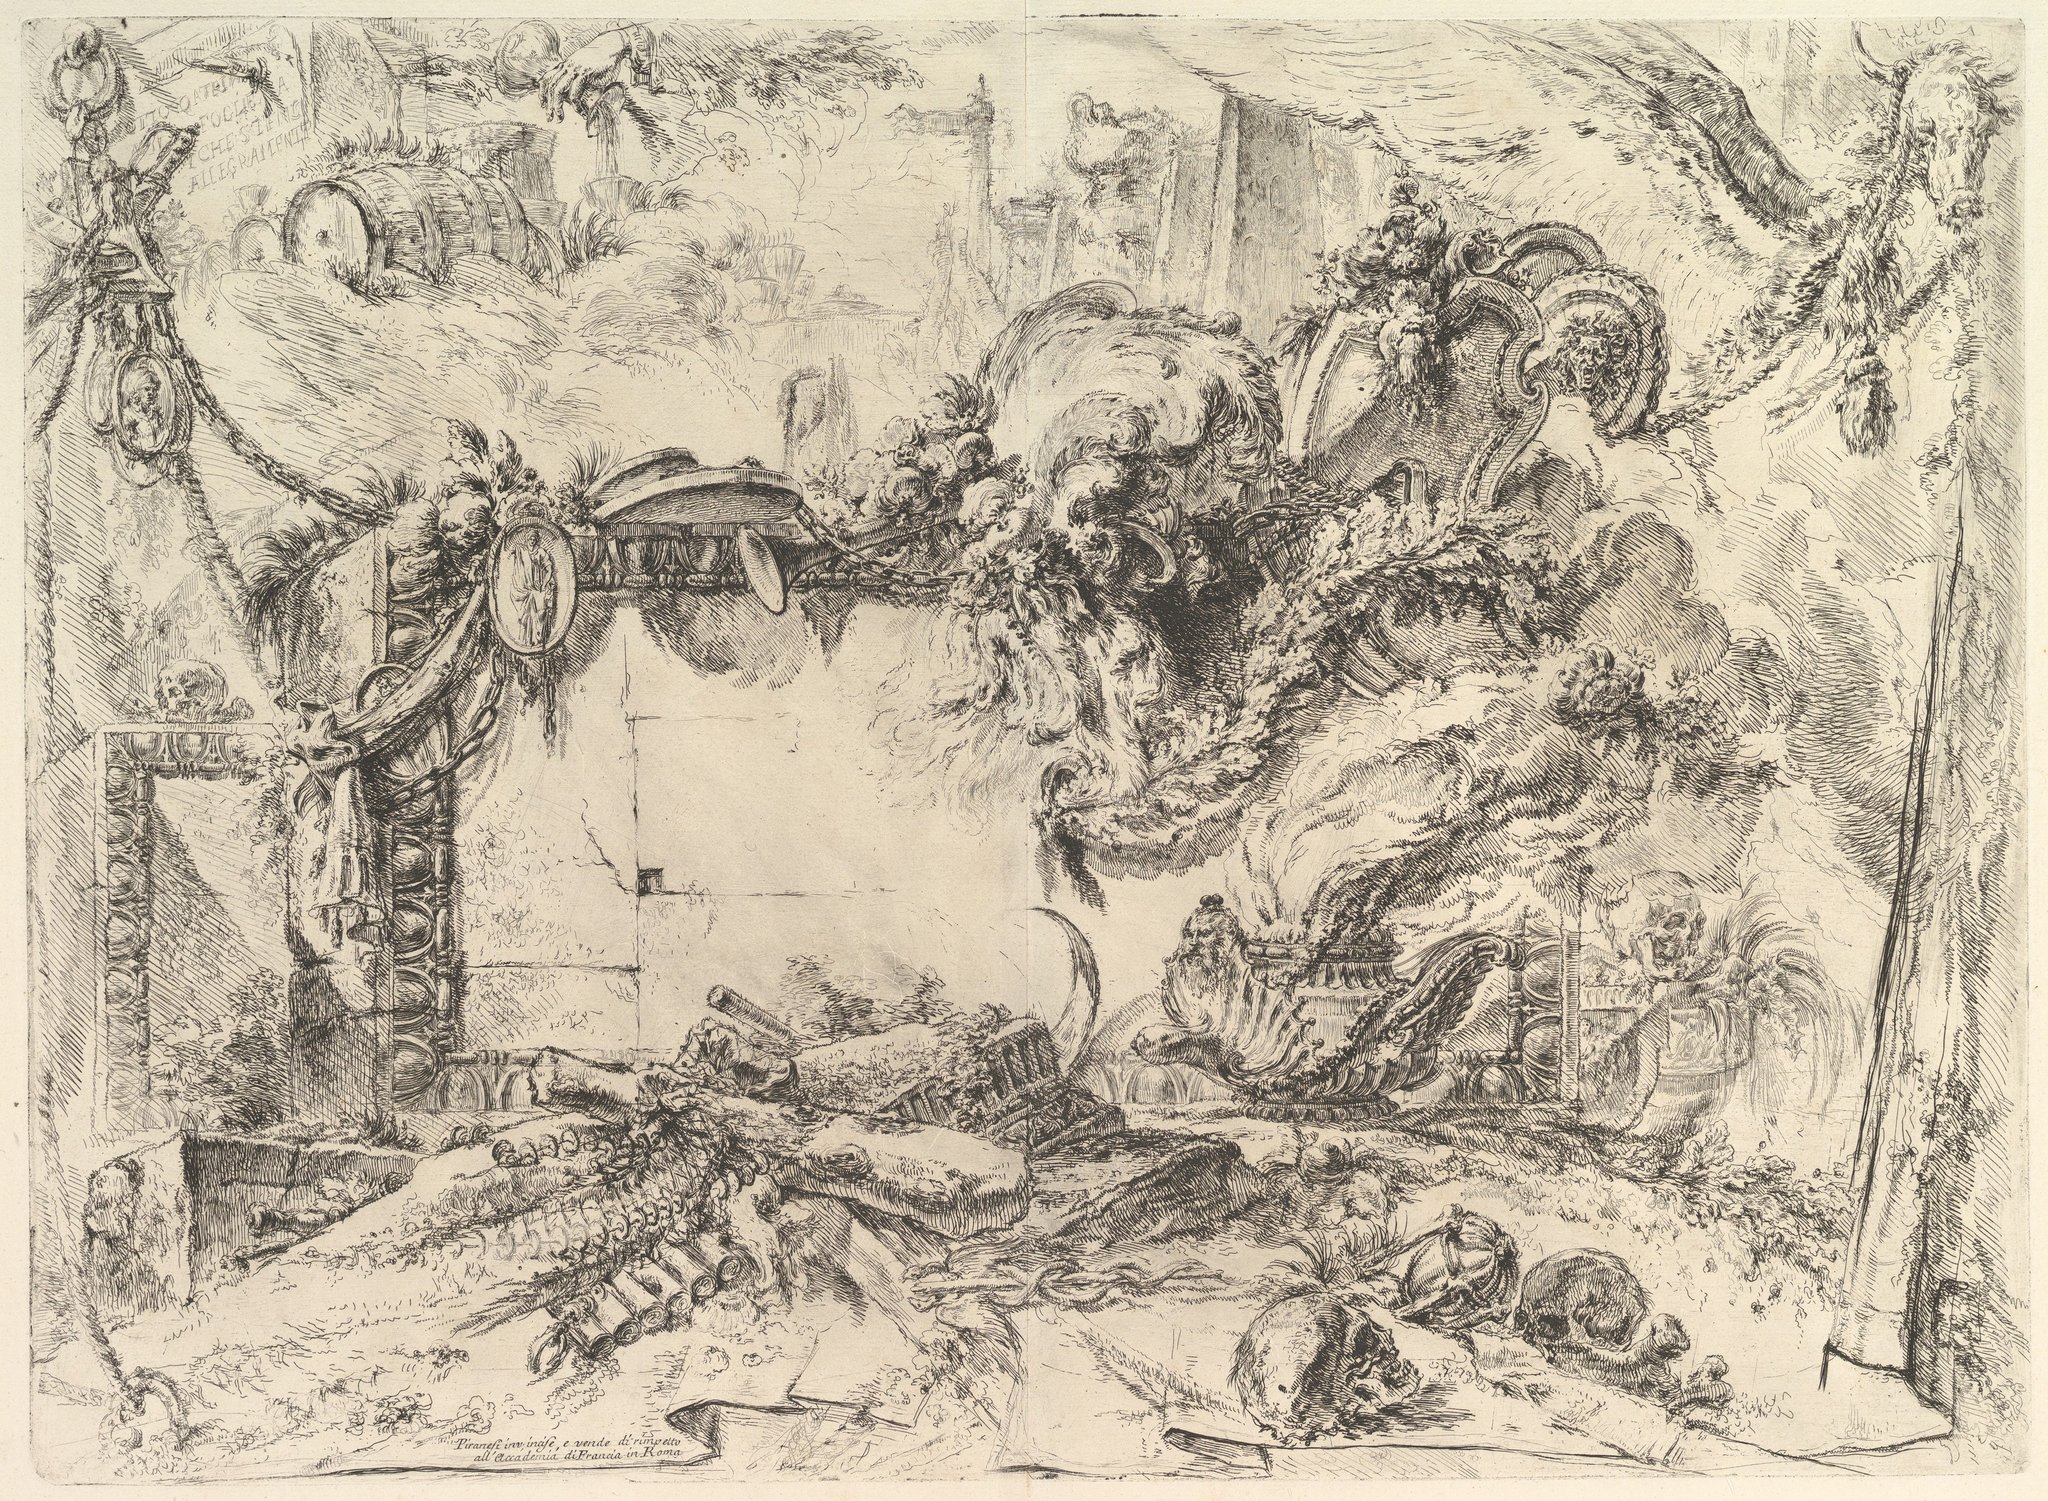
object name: print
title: The Monumental Tablet, from "Grotteschi" (Grotesques)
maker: giovanni battista piranesi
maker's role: artist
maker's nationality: italian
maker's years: 1720-1778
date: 1748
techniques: drypoint, engraving, etching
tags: grotesques